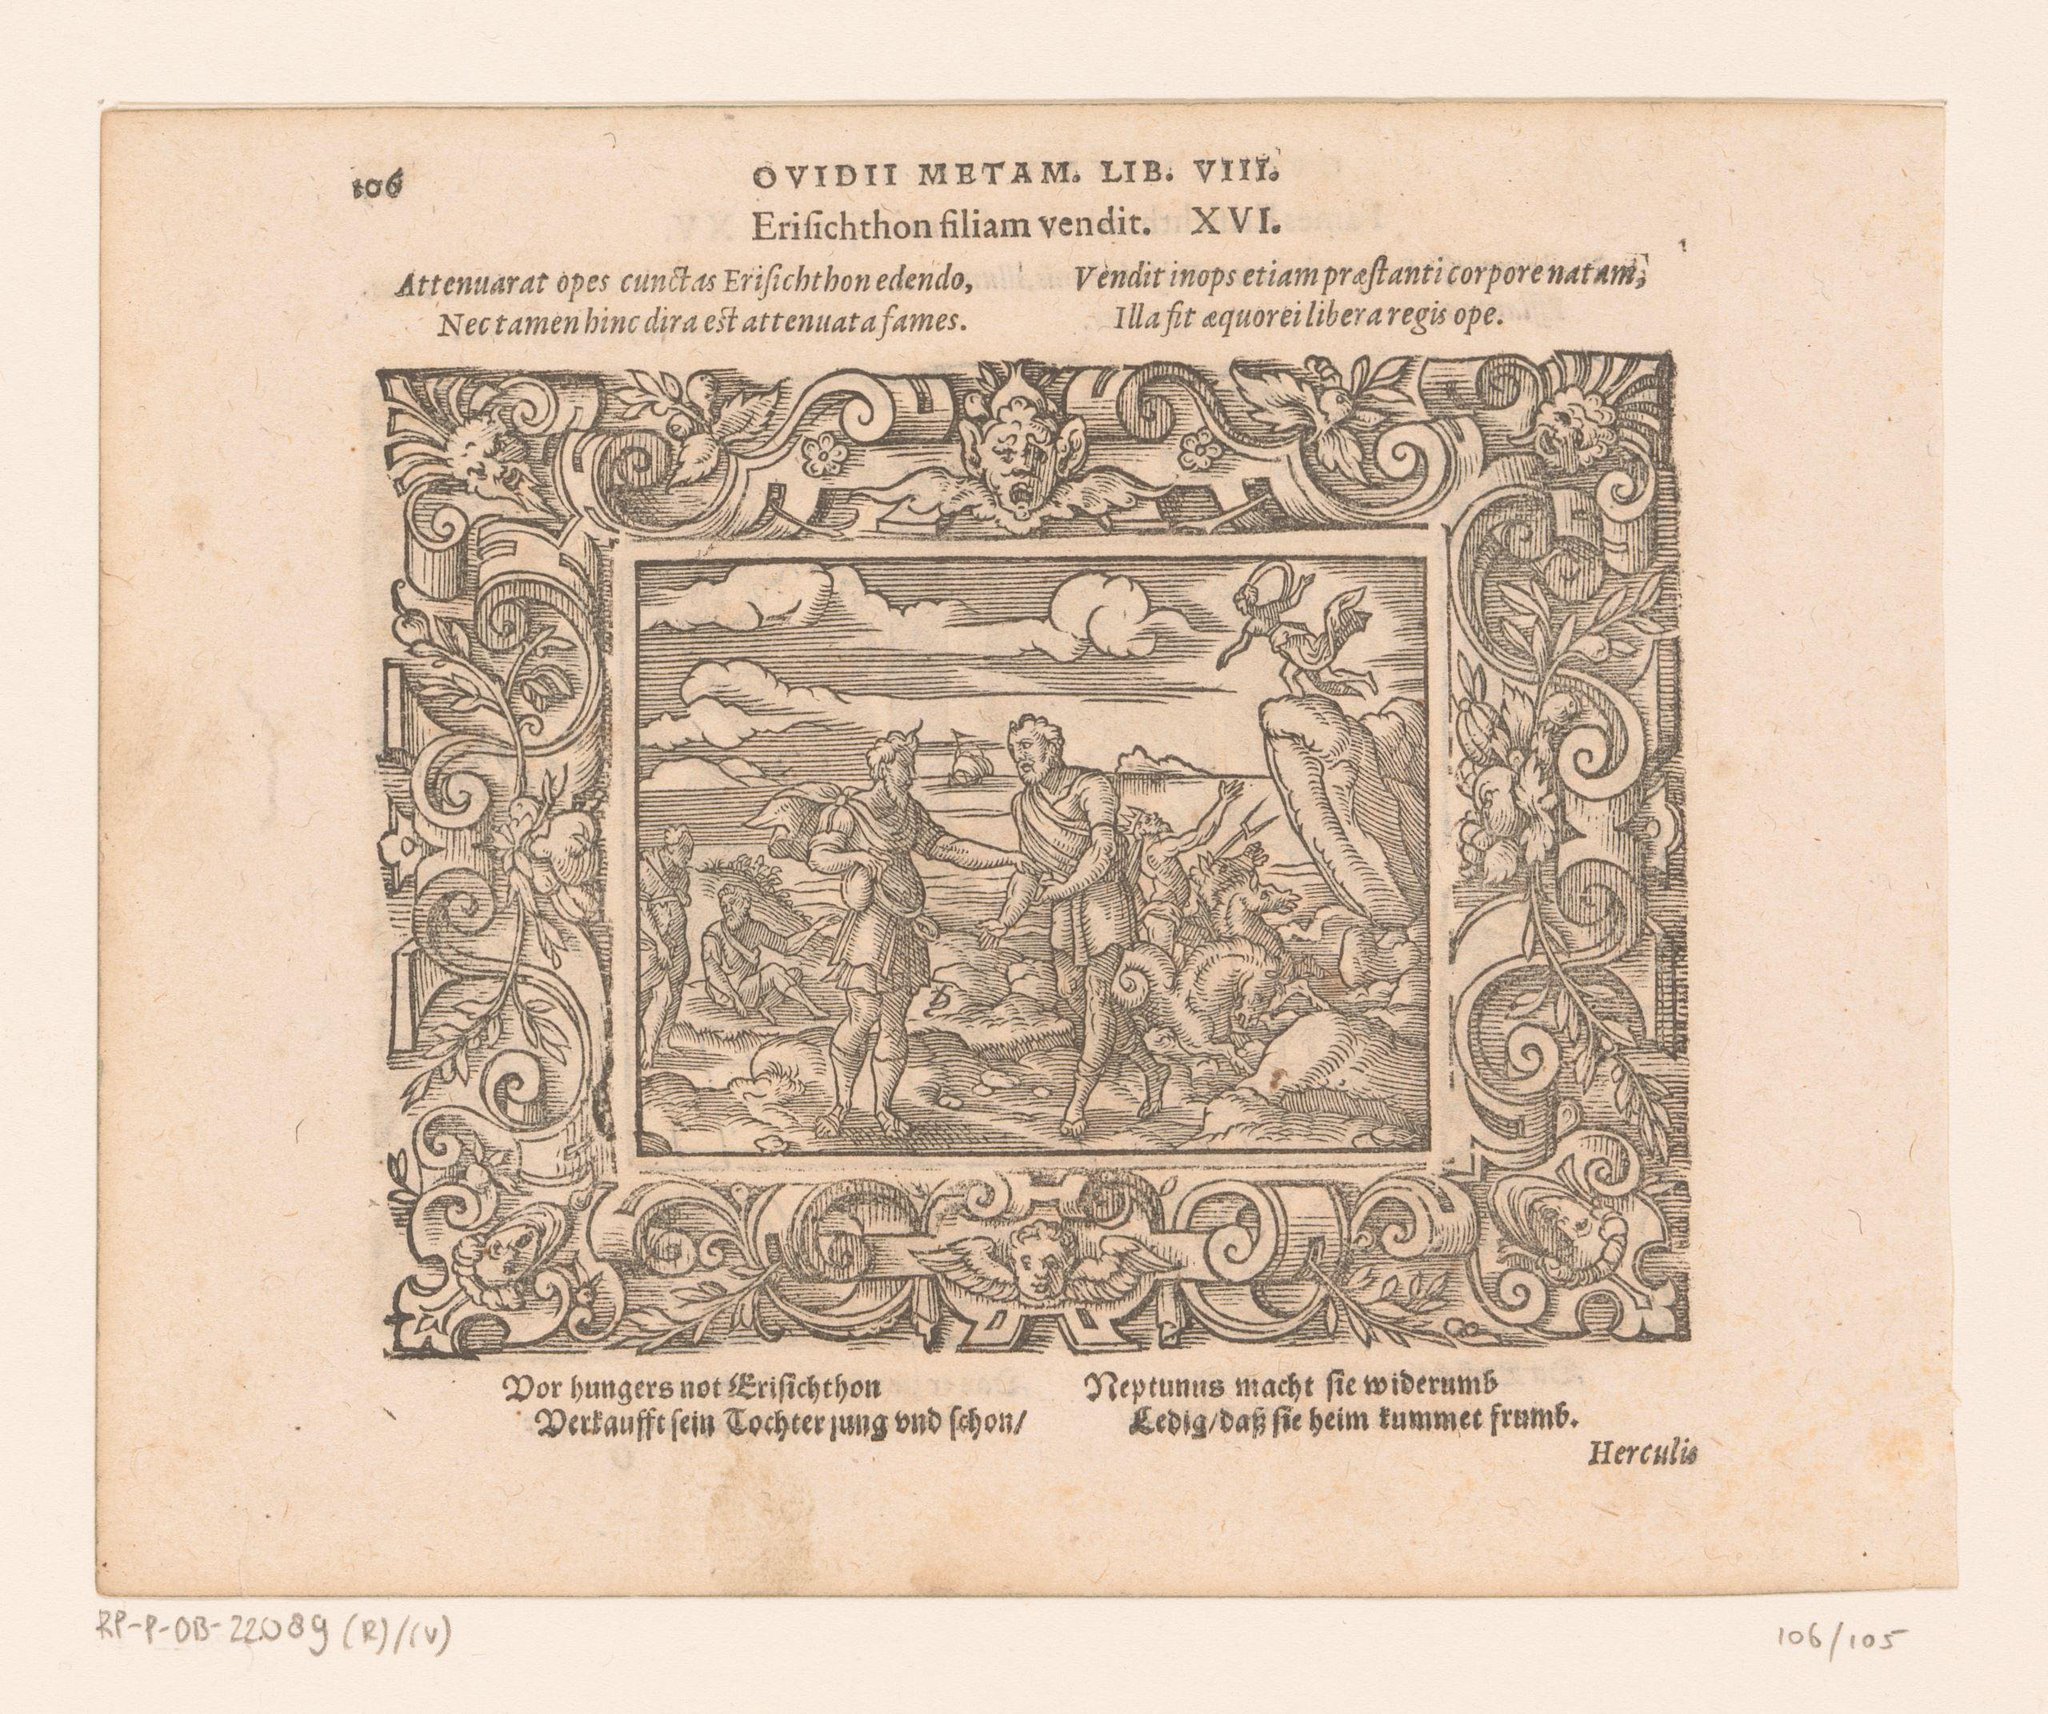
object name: book illustration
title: Erysichthon verkoopt zijn dochter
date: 1569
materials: paper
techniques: letterpress printing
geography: frankfurt am main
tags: scrollwork, strapwork ~ ornament, erysichthon, having squandered all his possessions, is supported by his daughter metra, who lets herself be sold in various forms, me(s)tra changed into various forms: to support her famished father erysichthon, me(s)tra changes herself into various forms (ovid, metamorphoses viii 872)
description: Illustratie bij de Metamorfosen van Ovidius, afkomstig uit de publicatie: Posthius, Johannes. Tetrasticha in Ovidii metam. Frankfurt am Main: Georg Rab en Sigmund Feyerabend en erven Weigand Han, 1569. De voorstellingen en ornamentranden van deze boekillustraties zijn van twee aparte blokken gedrukt. Beide werden afzonderlijk van elkaar ook gebruikt voor andere publicaties, en de ornamentranden werden eveneens binnen deze publicatie meerdere keren gebruikt.